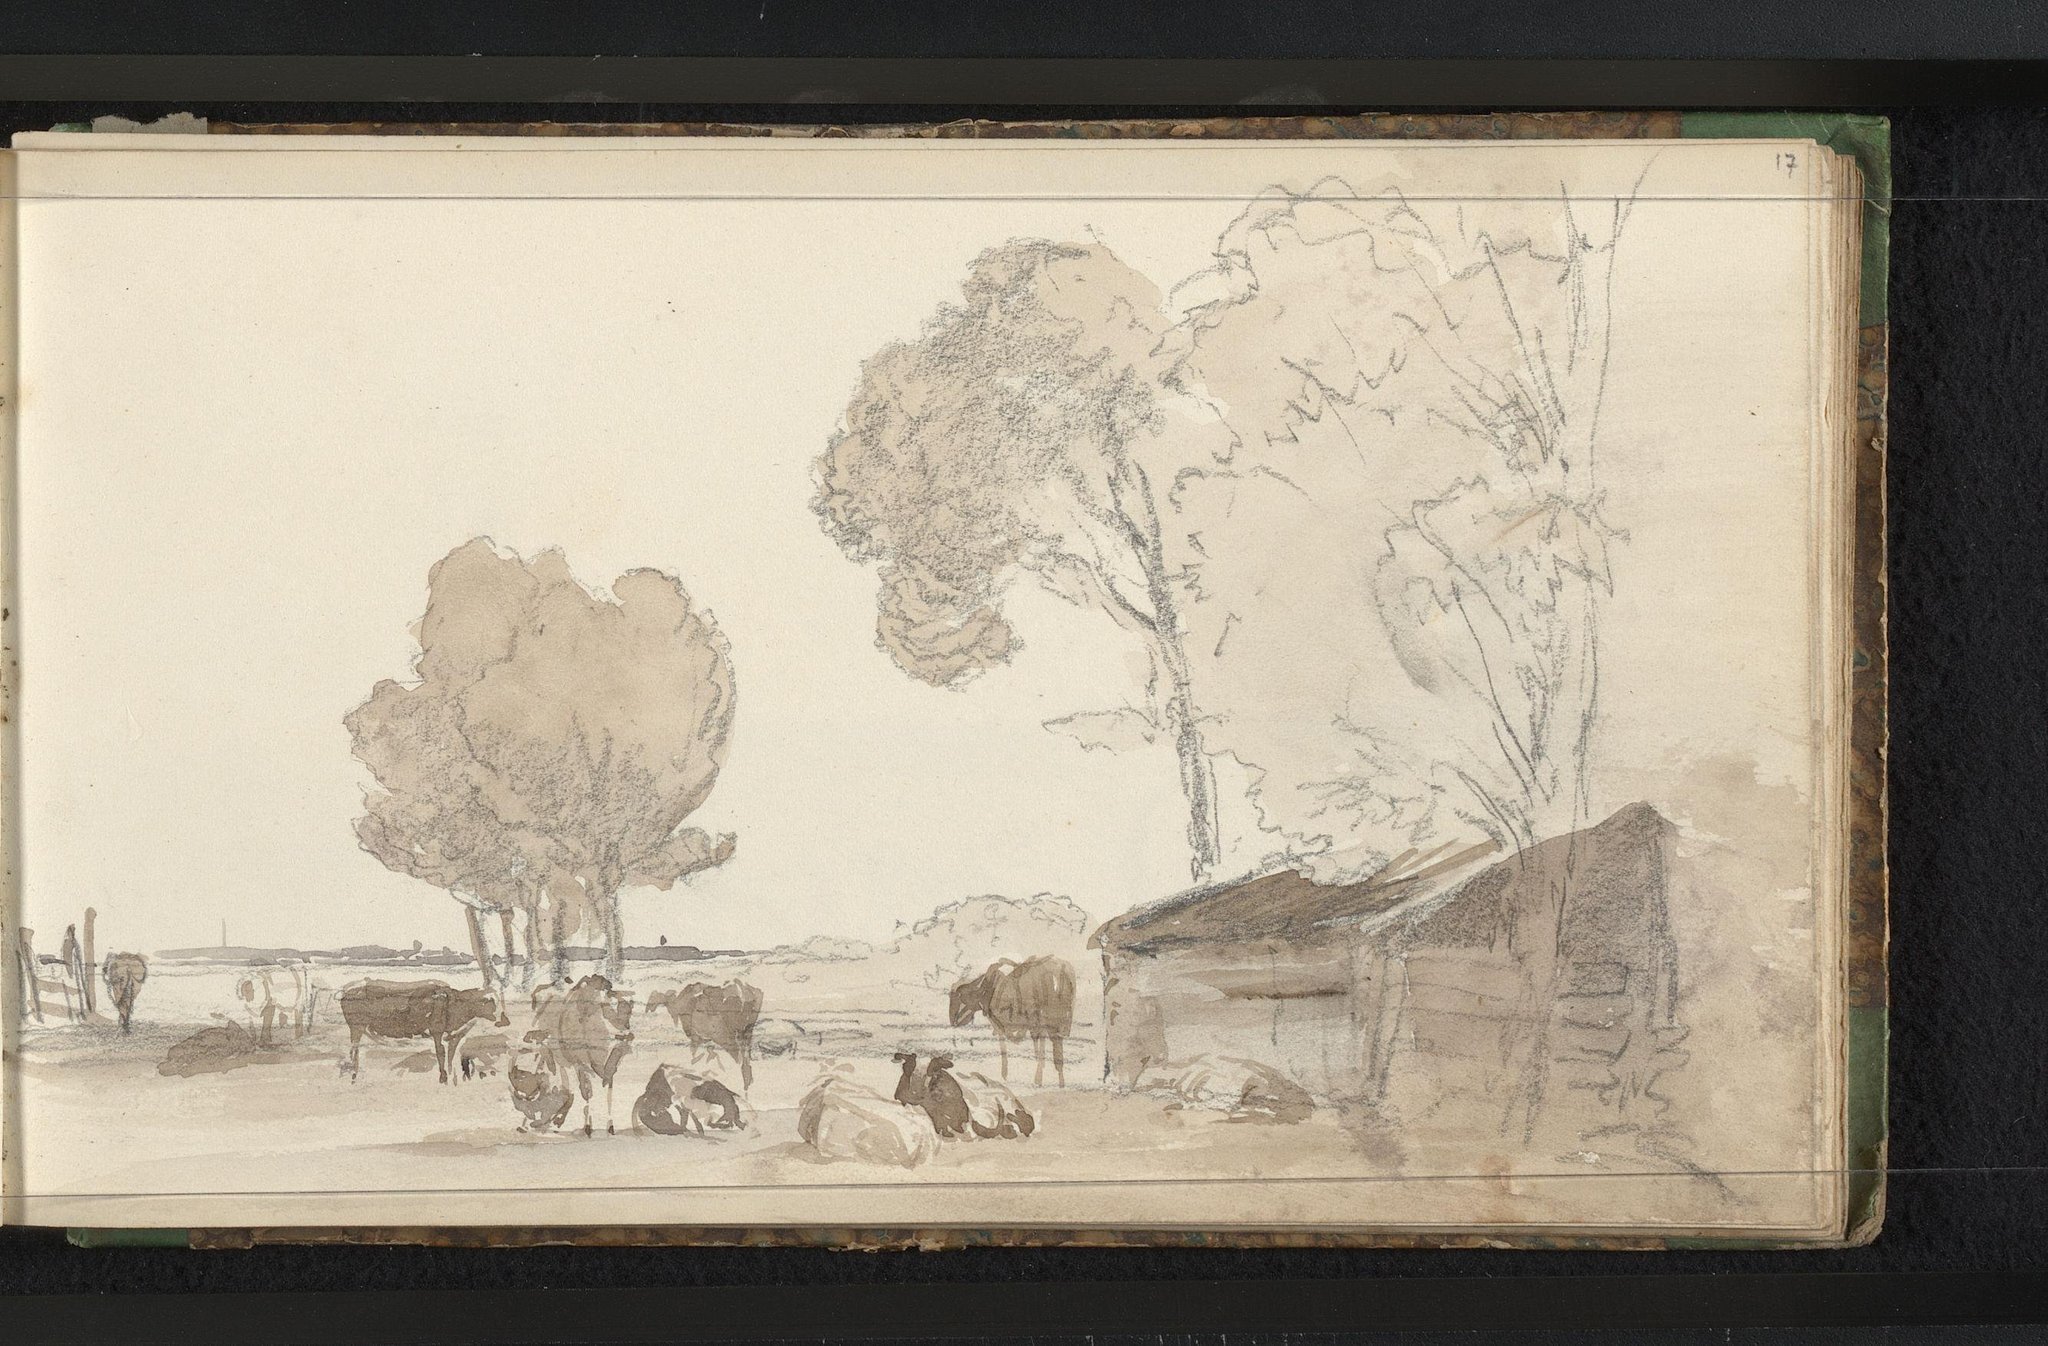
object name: sketchbook leaf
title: Runderen in een weiland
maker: jan bedijs tom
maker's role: draughtsman, painter, print maker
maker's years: 1813-1894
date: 1828-1894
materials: paper, pencil, watercolor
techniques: brush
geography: the hague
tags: trees, landscapes, artist (in general) making preliminary designs, sketching, bovine cattle, farm or solitary house in landscape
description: Pagina 17 recto uit een schetsboek met 50 bladen.